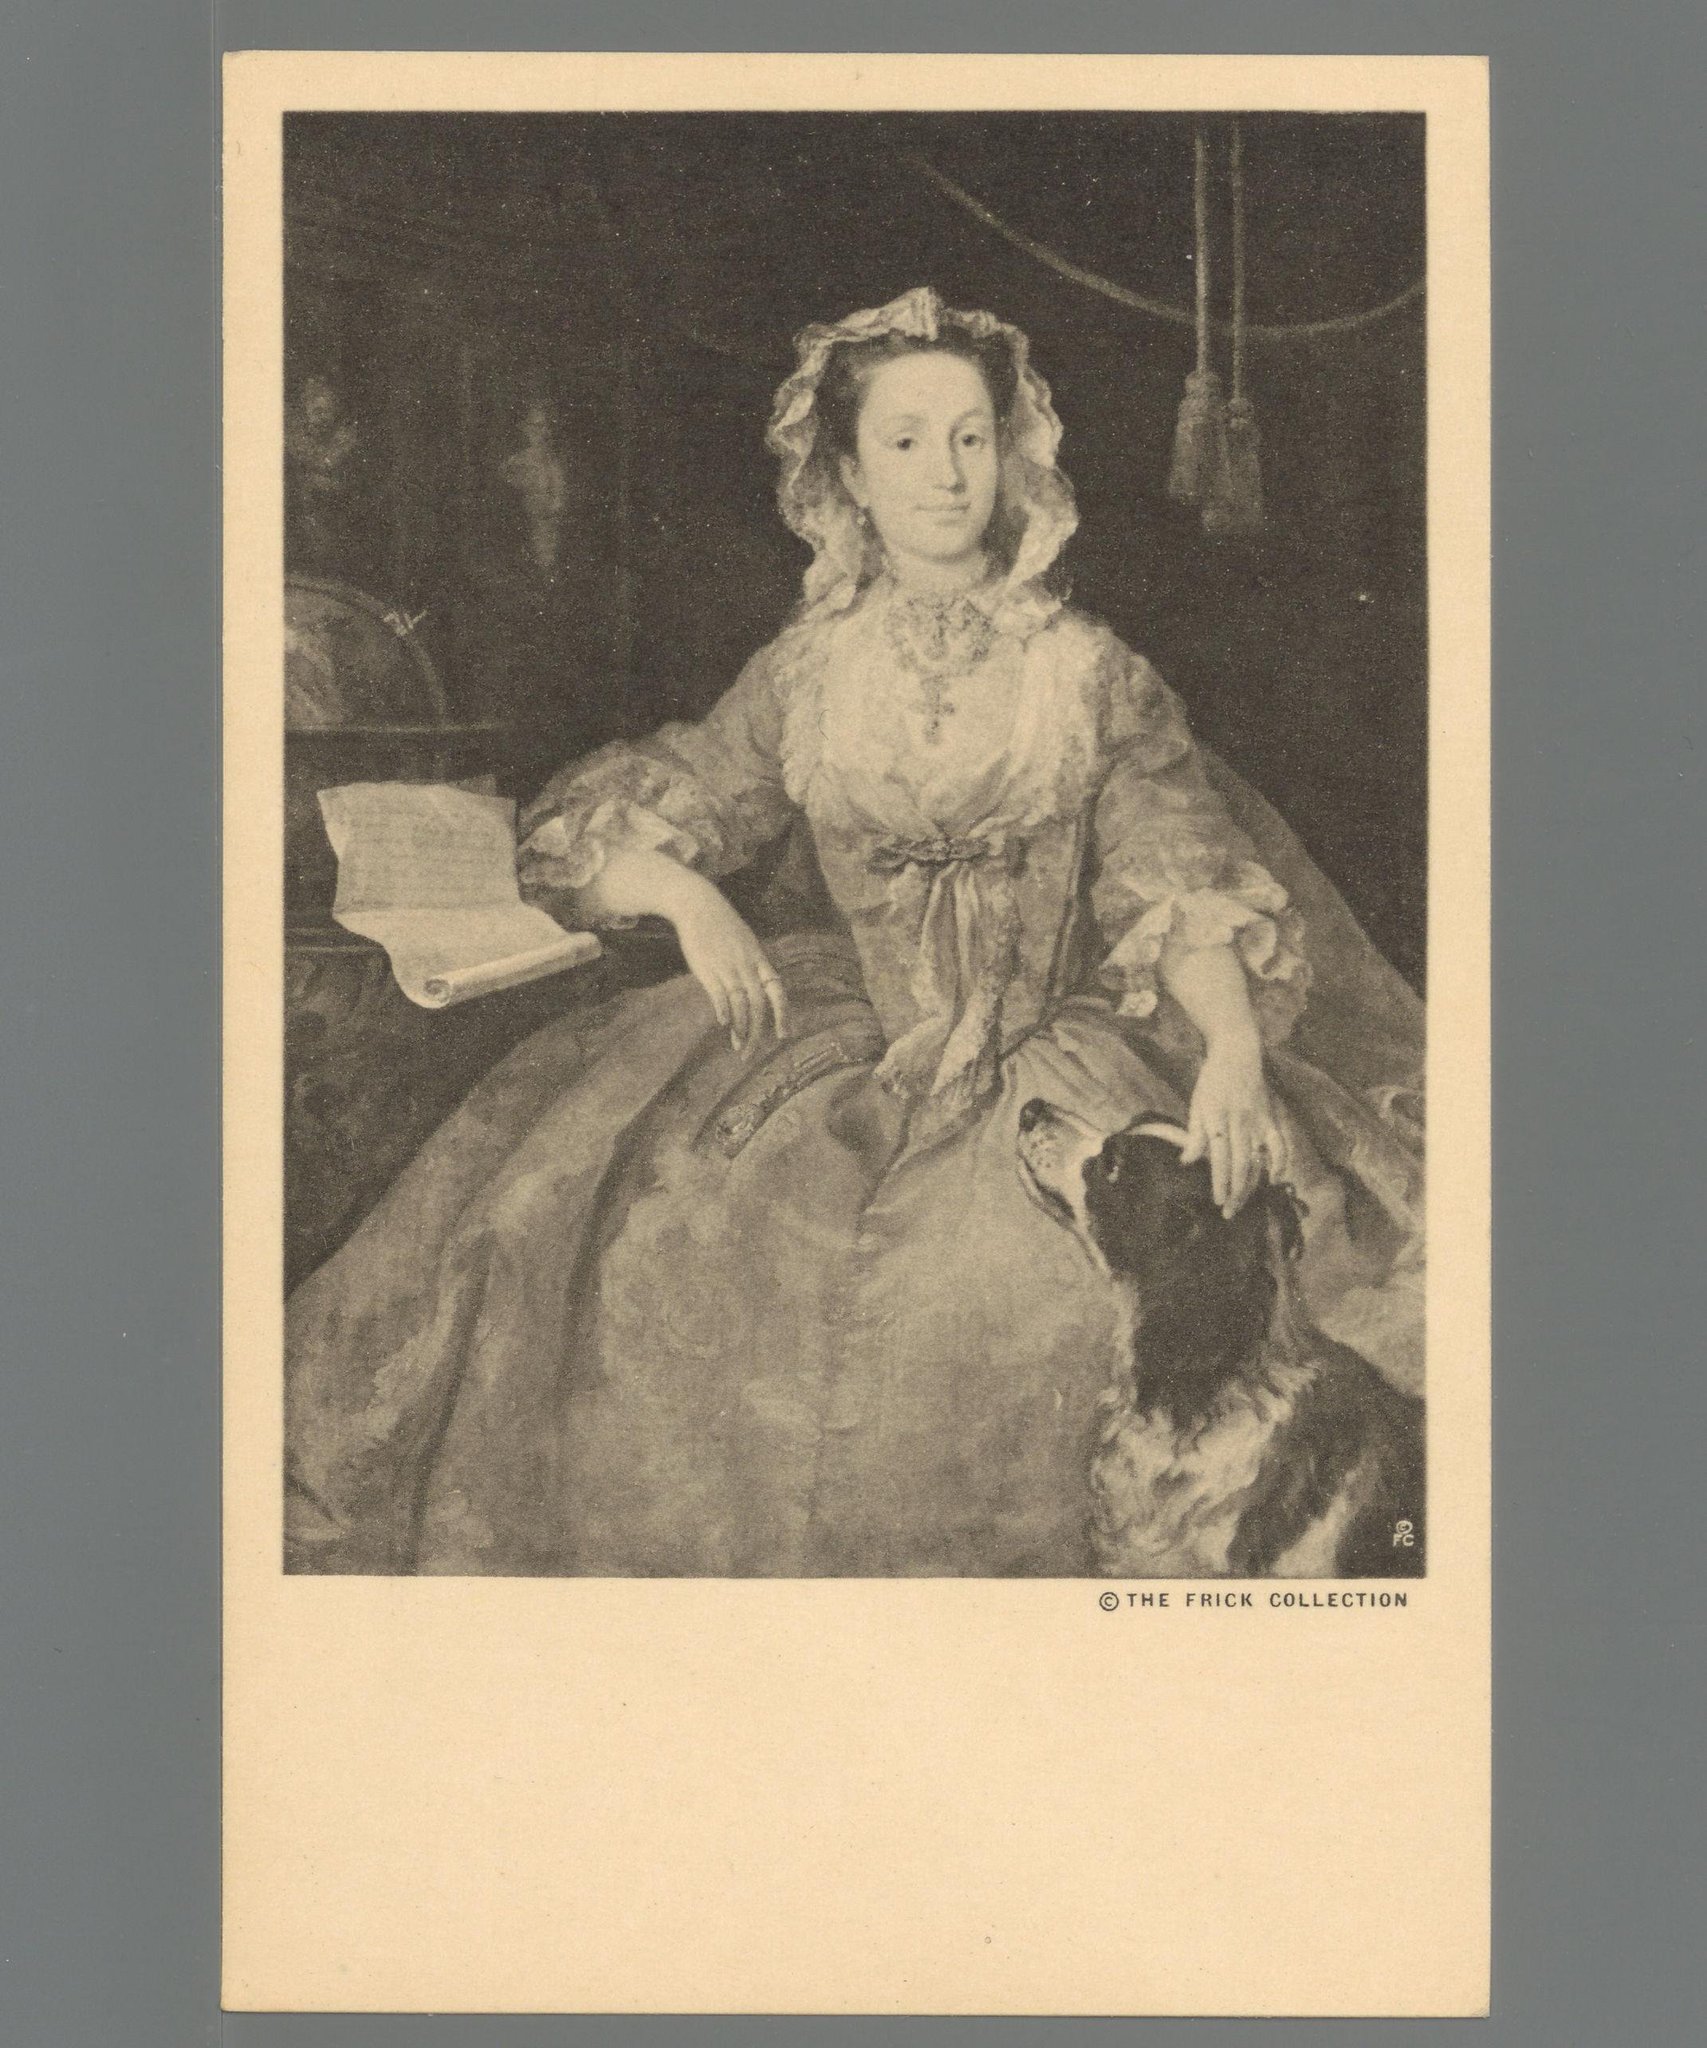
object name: ansichtkaart, prentbriefkaart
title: Miss Mary Edwards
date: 1914-1940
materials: cardboard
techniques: photograph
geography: new york city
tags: london, adult woman, historical persons, dog